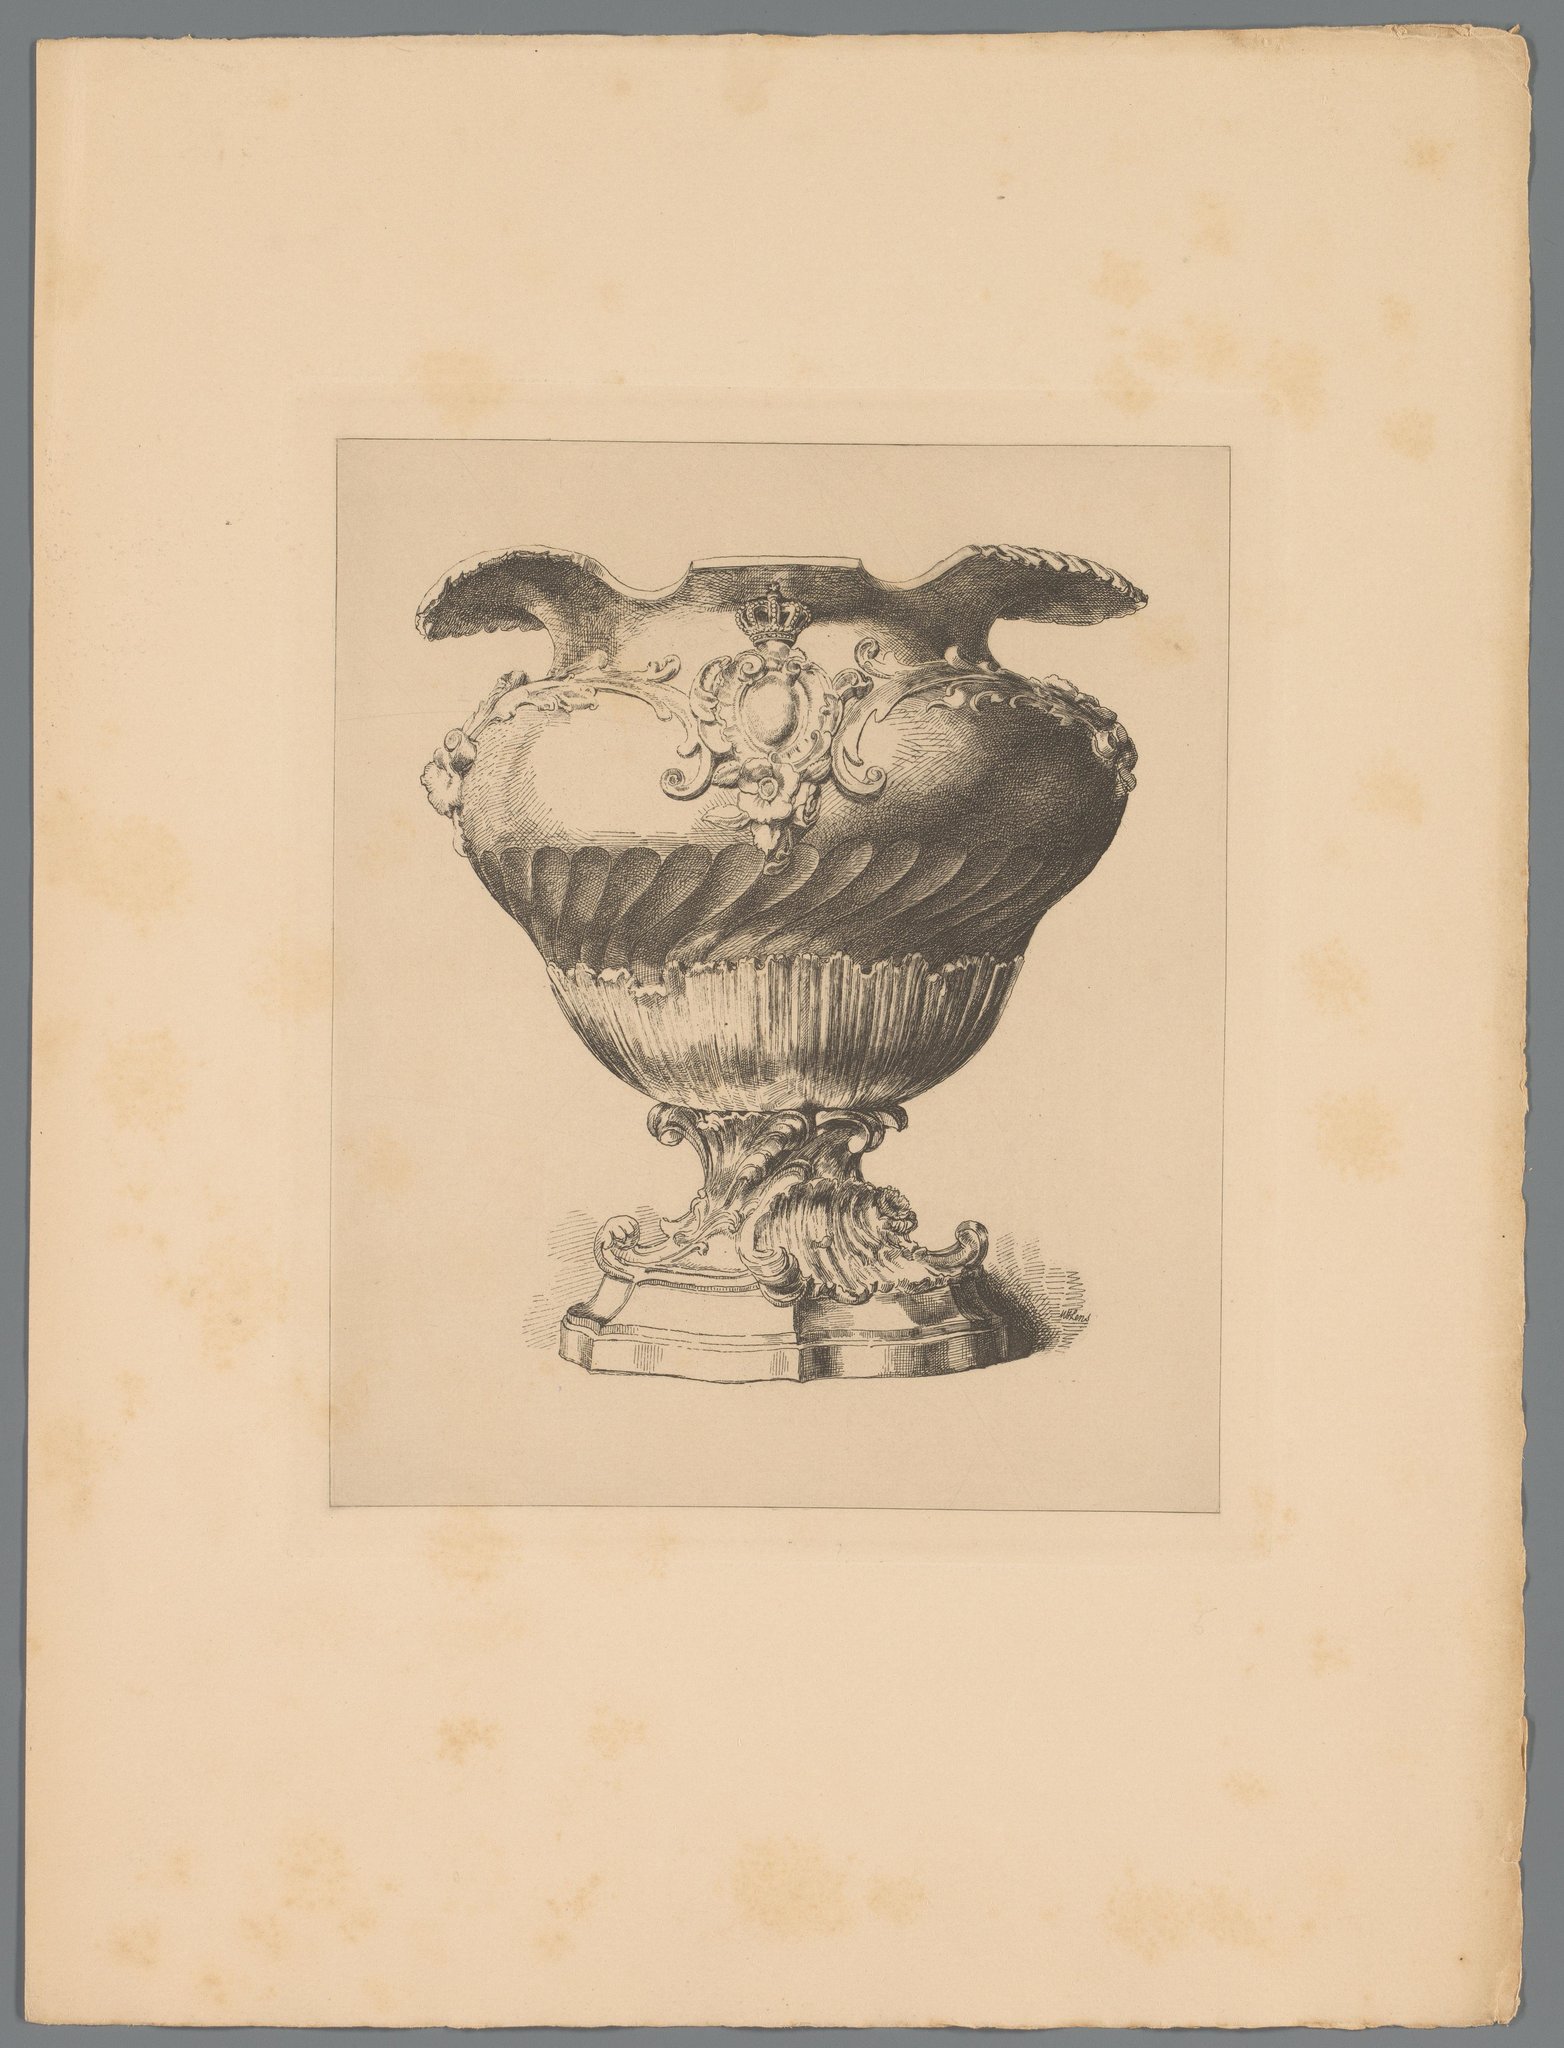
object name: print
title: Vooraanzicht van een grote ovale vaas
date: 1889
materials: paper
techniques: etching, intaglio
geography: utrecht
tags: vase ~ ornament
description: Prent maakt deel uit van een serie van veertien prenten.